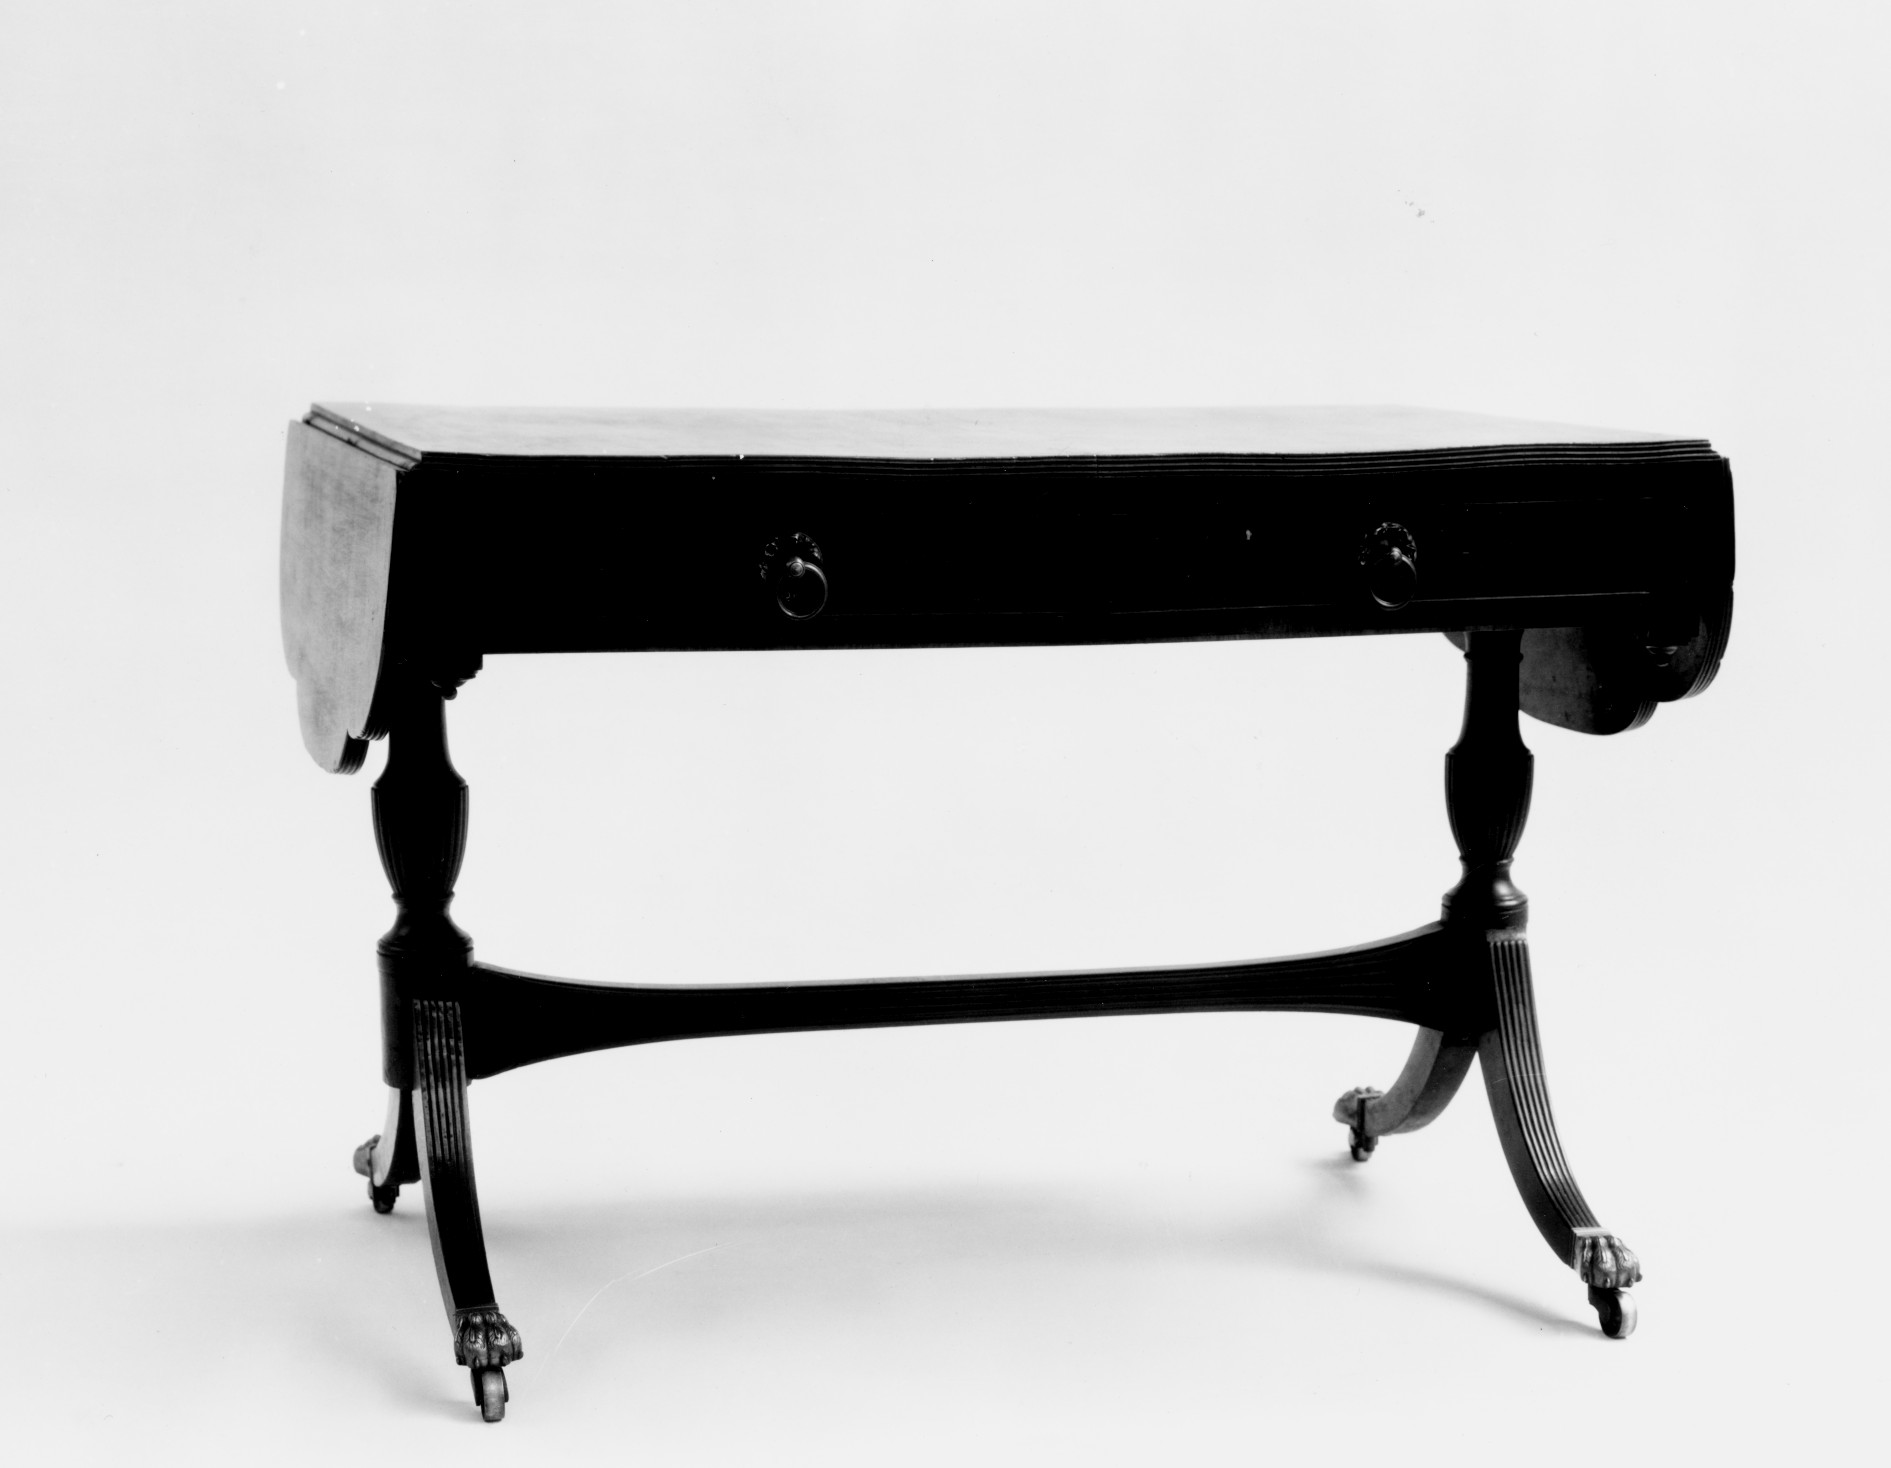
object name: drop leaf table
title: Drop-leaf Table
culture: american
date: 1800-1815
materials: wood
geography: united states